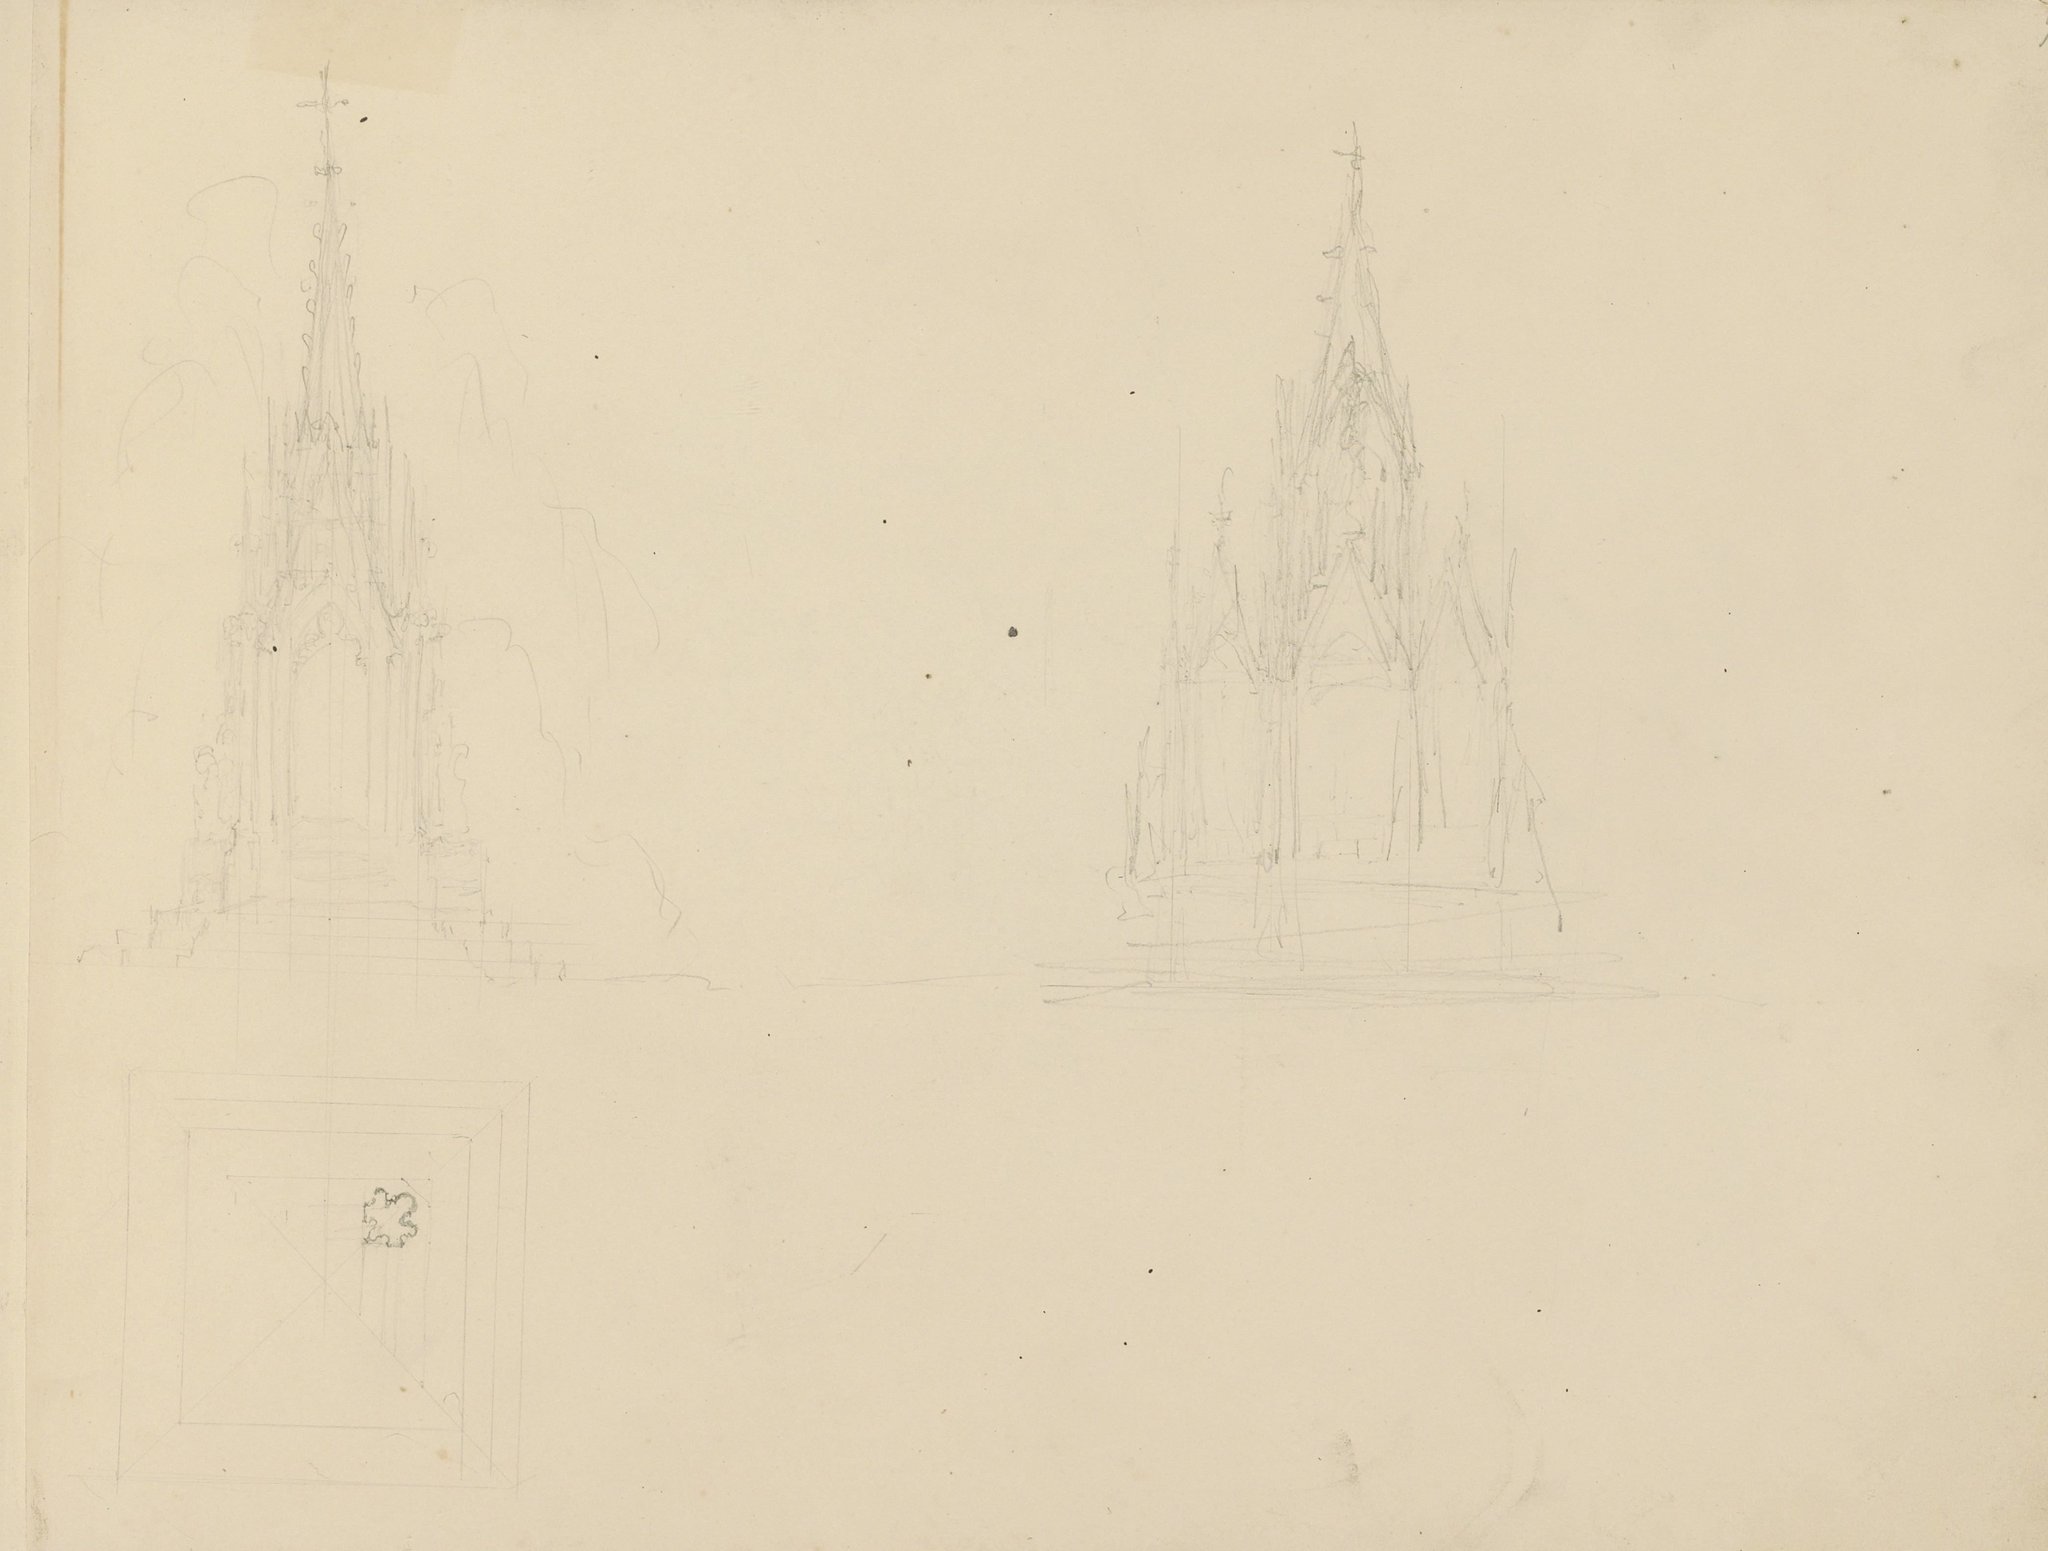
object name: sketchbook leaf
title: Twee gotische monumenten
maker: pierre joseph hubert cuypers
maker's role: draughtsman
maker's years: 1827-1921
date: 1850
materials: paper, pencil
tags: monument, statue, plan ~ architecture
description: Tevens een studie van een plattegrond. Blad 9 recto uit een schetsboek met 37 bladen.